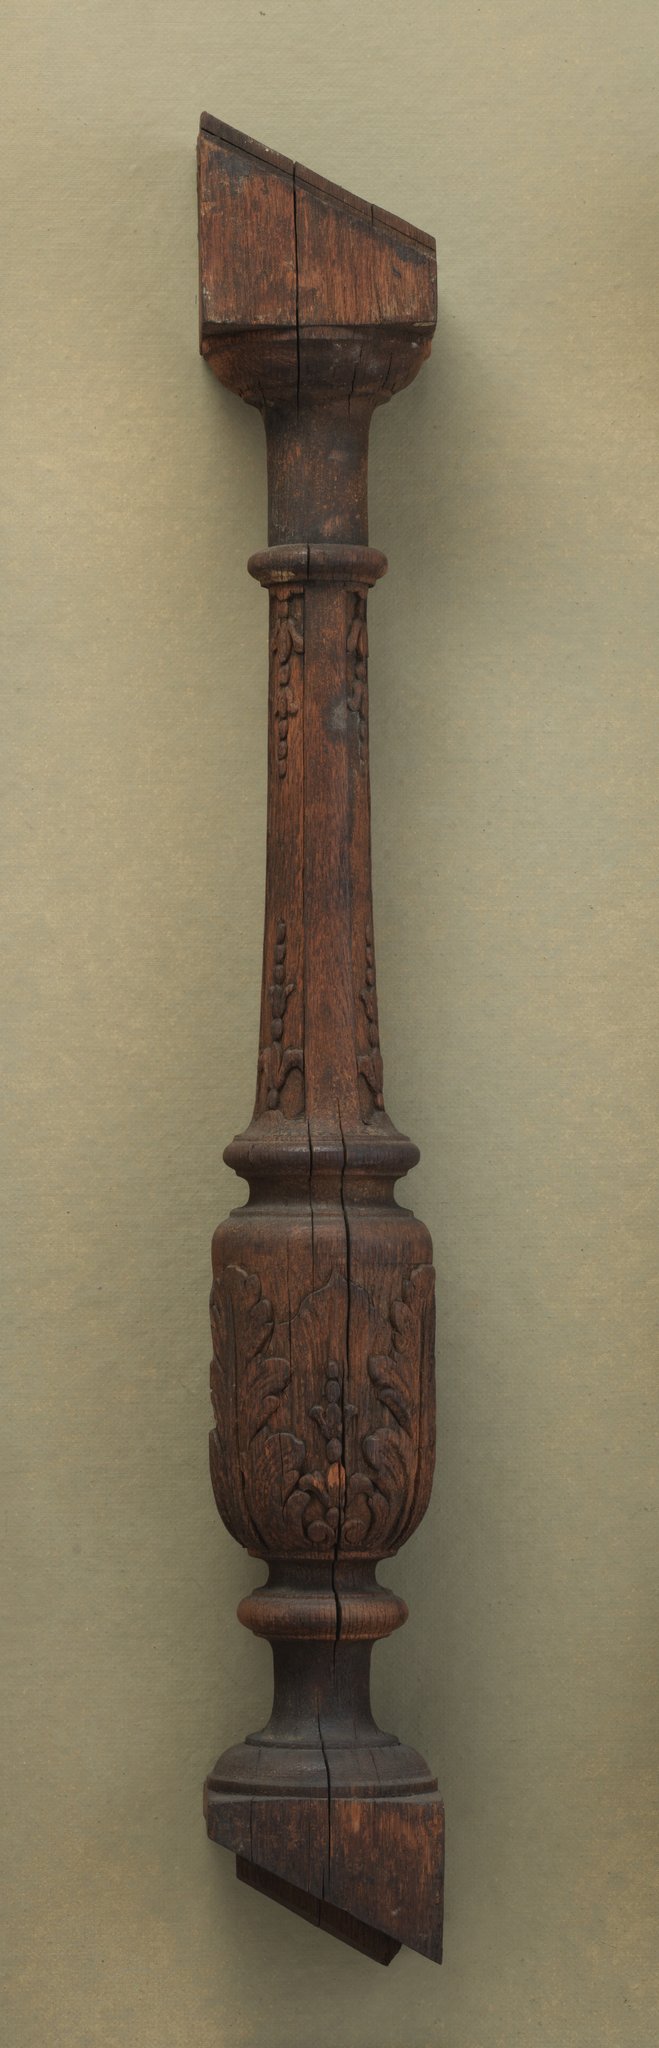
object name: baluster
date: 1651-1700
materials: wood